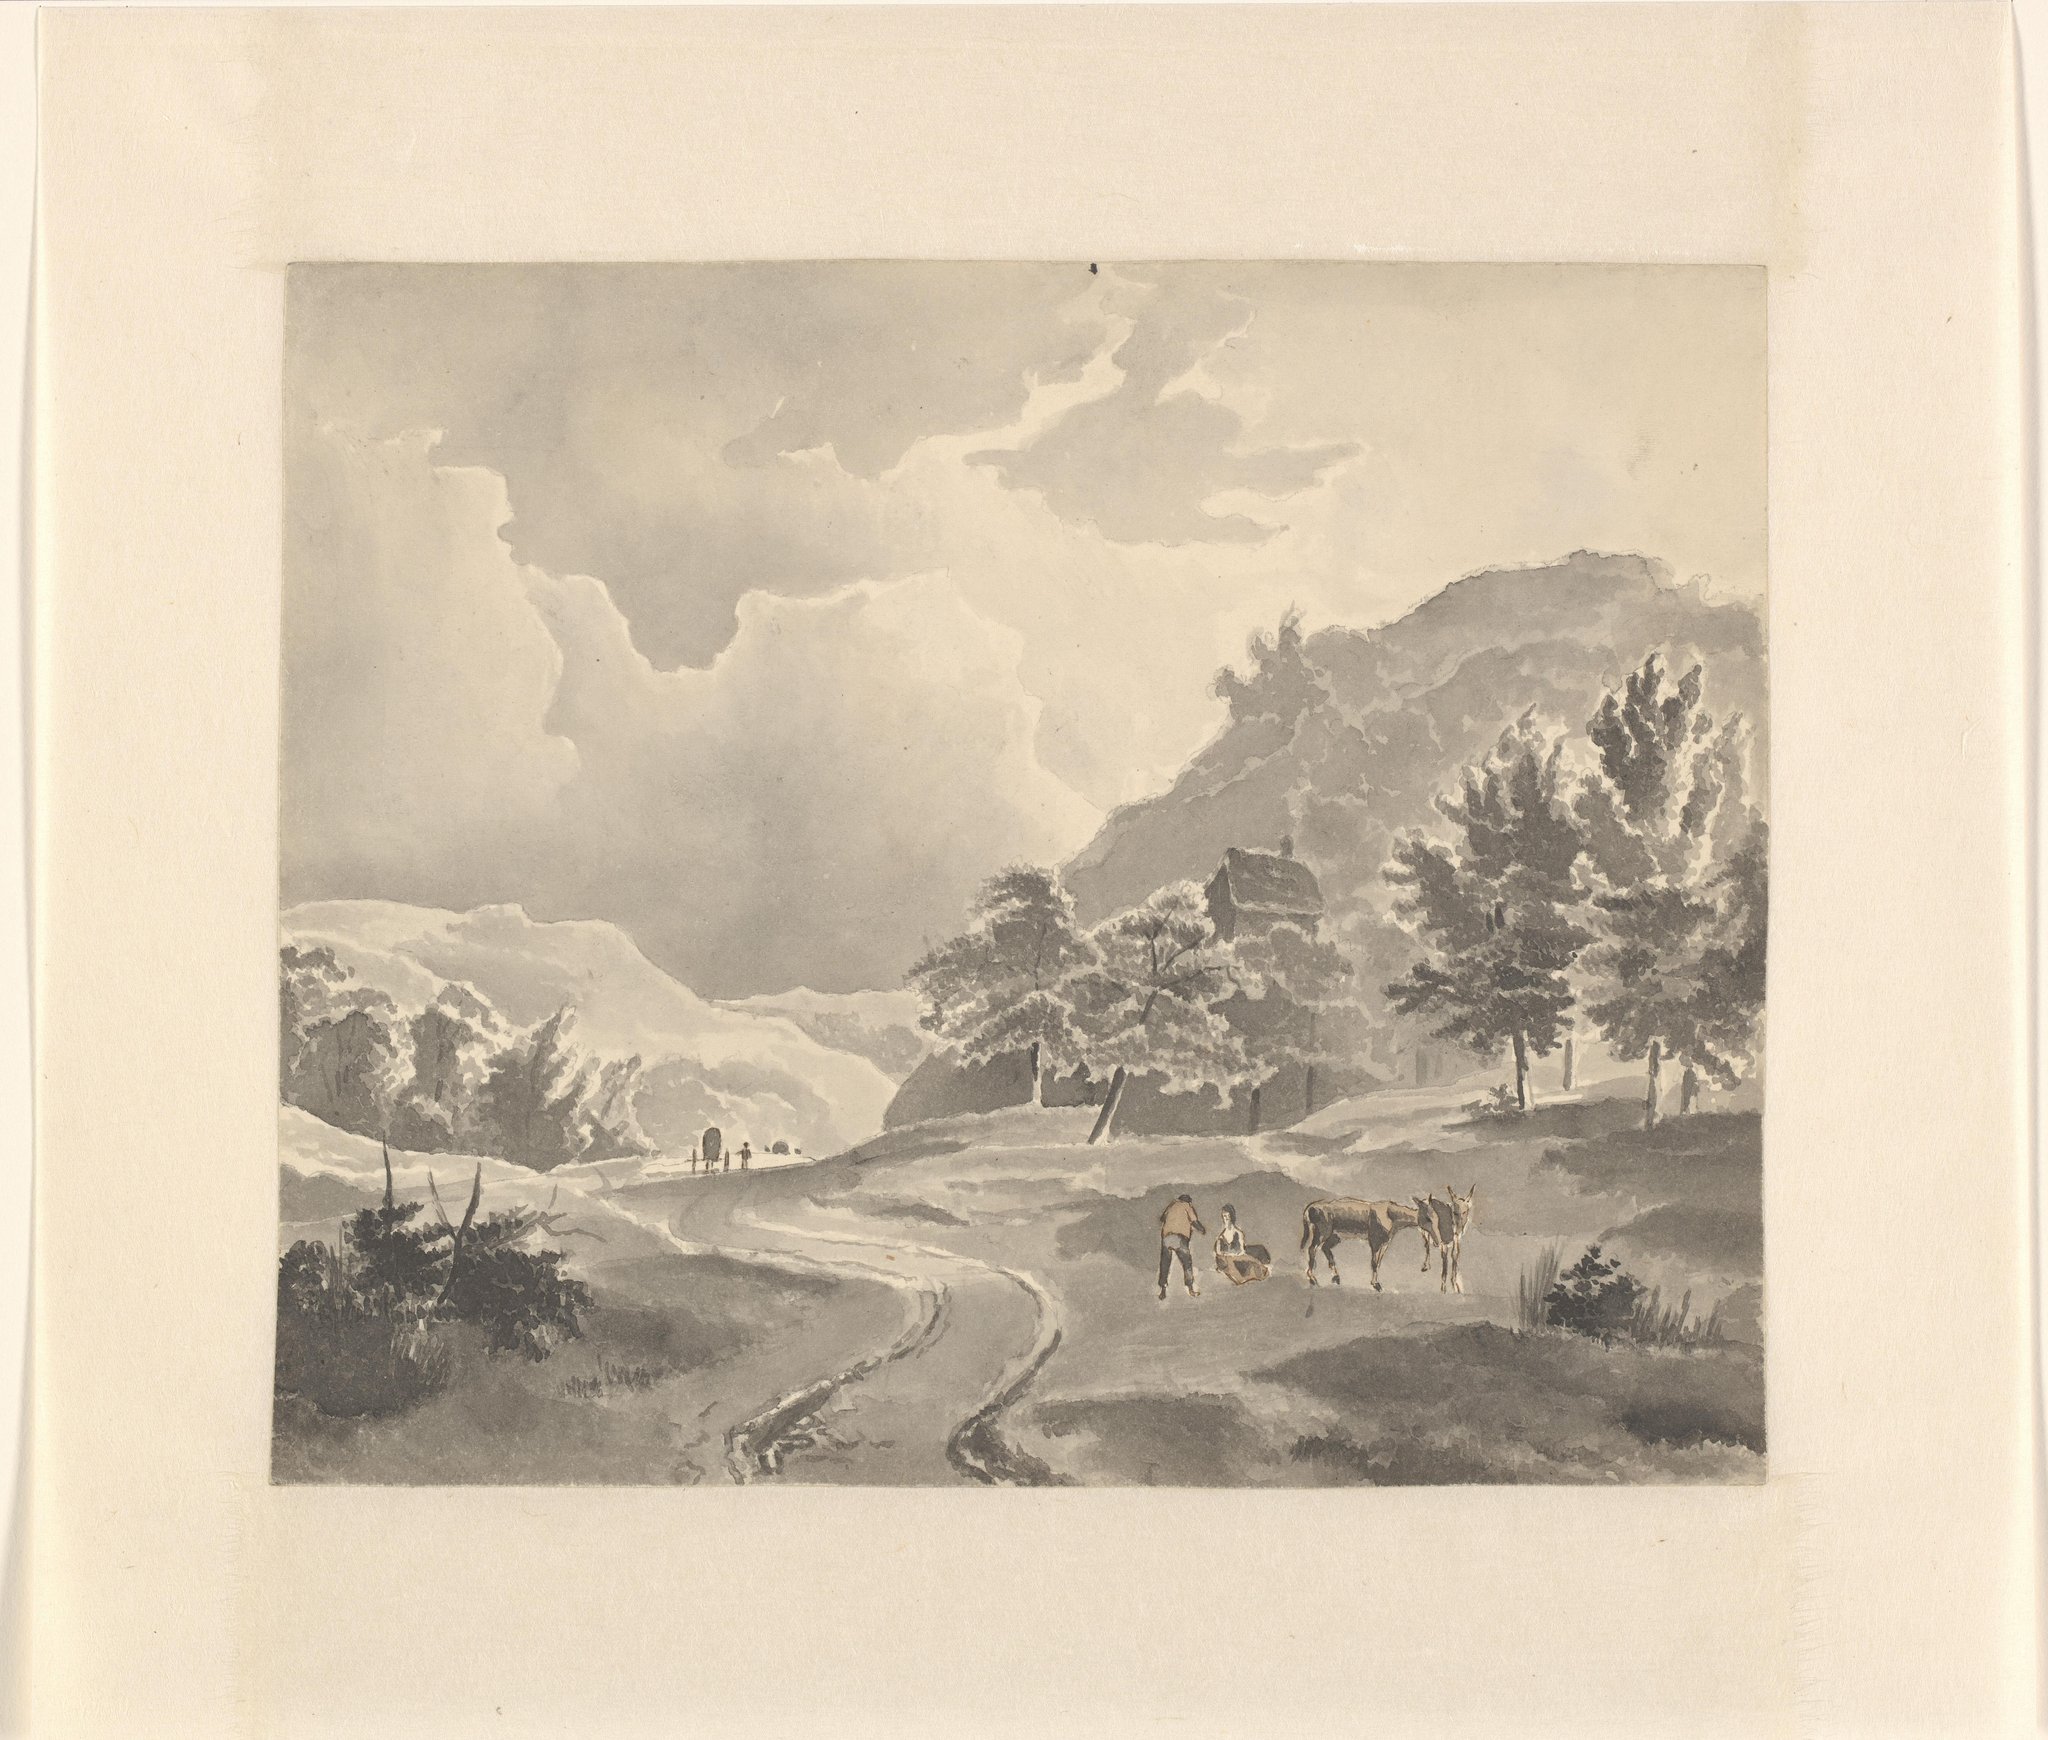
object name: drawing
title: Figuren en paarden langs een pad in een berglandschap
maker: johannes van reijn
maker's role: draughtsman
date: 1845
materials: ink, paper, pencil, watercolor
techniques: brush, pen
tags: (traveller) resting in the open air, mountains (+ landscape with figures, staffage)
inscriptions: inscription: ‘1845 by Mr. V.B.’